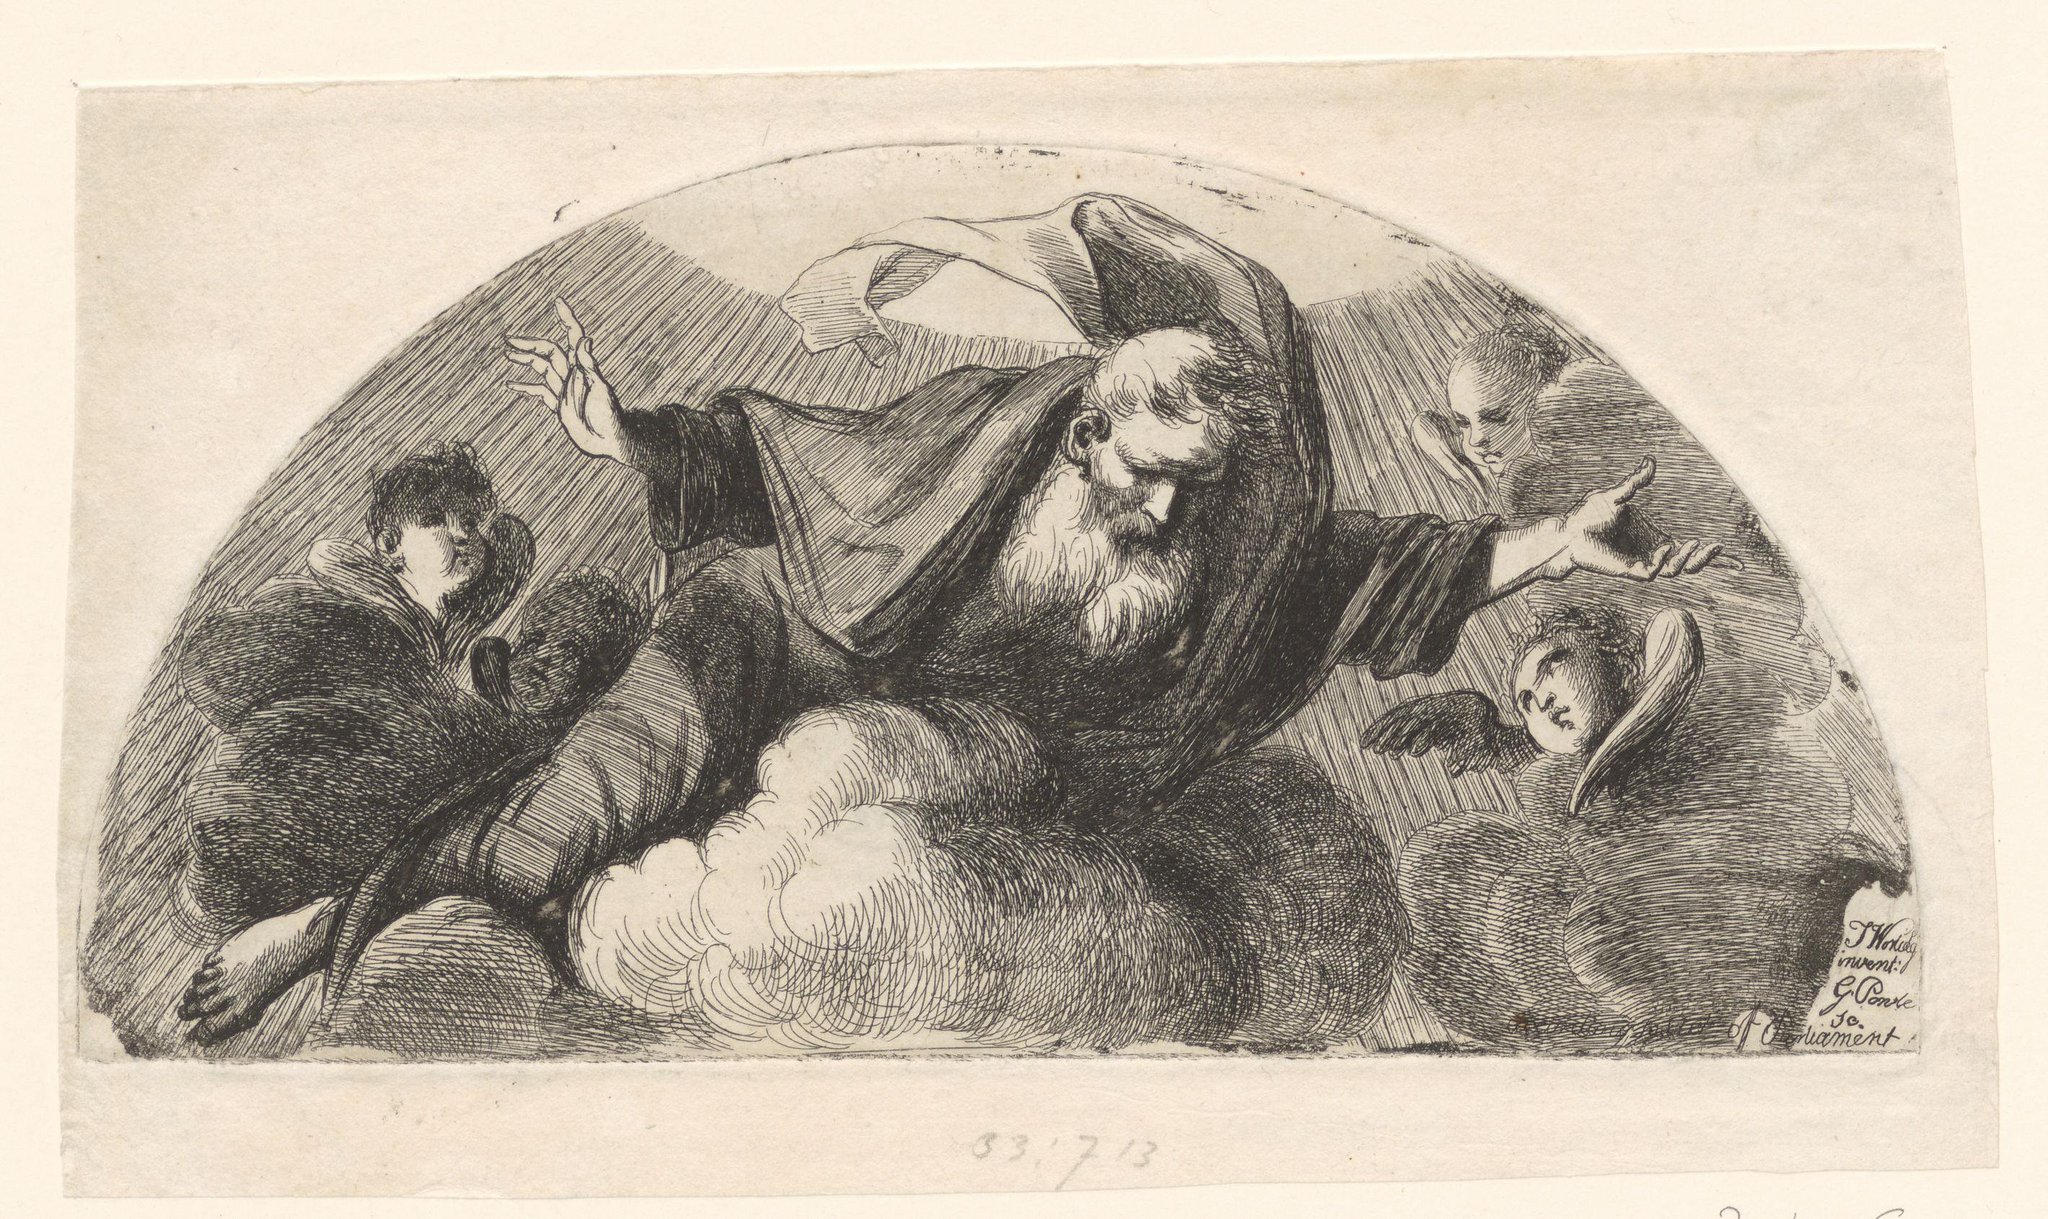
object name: print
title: God met cherubijnen in wolken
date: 1710-1766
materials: paper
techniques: etching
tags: cherubs, i.e. children's heads with wings, god the father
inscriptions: collector's mark: Lugt 2760, collector's mark: Lugt 2228